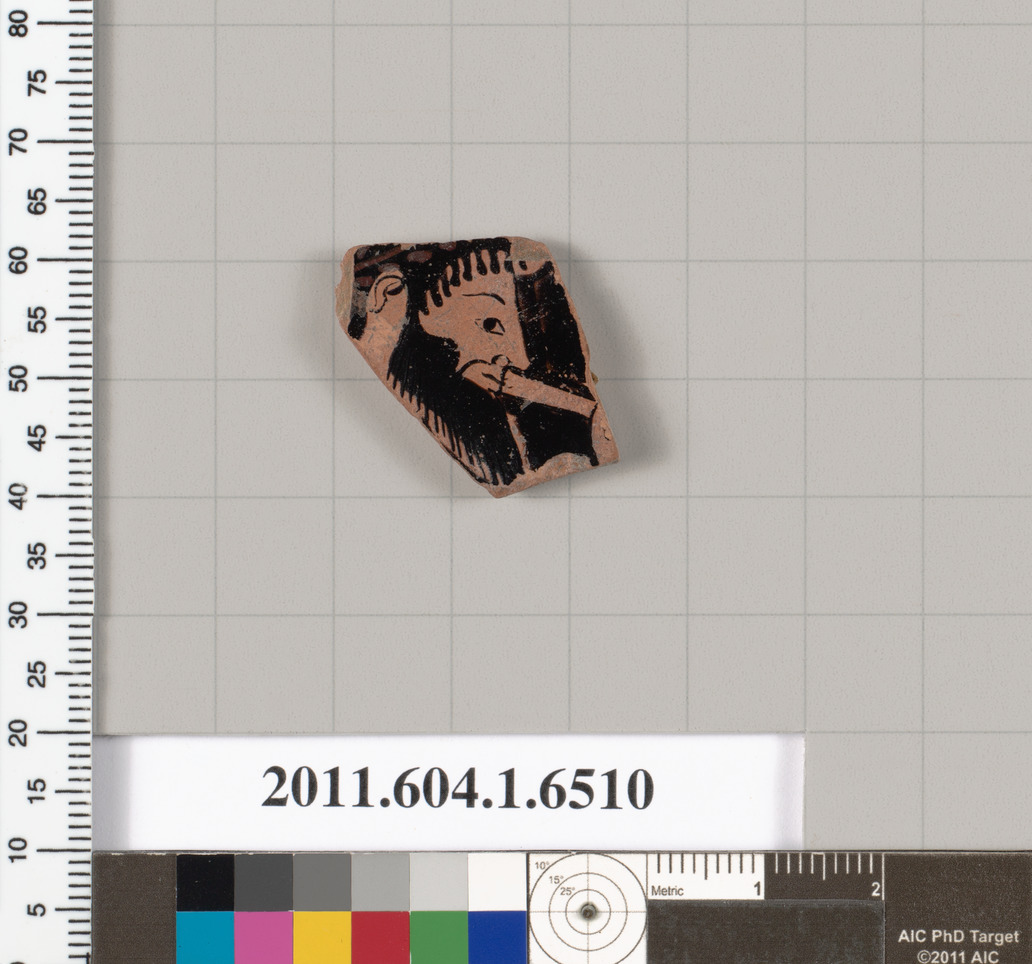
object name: kylix fragment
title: Terracotta fragment of a kylix (drinking cup)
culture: greek, attic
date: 490-480 BCE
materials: terracotta